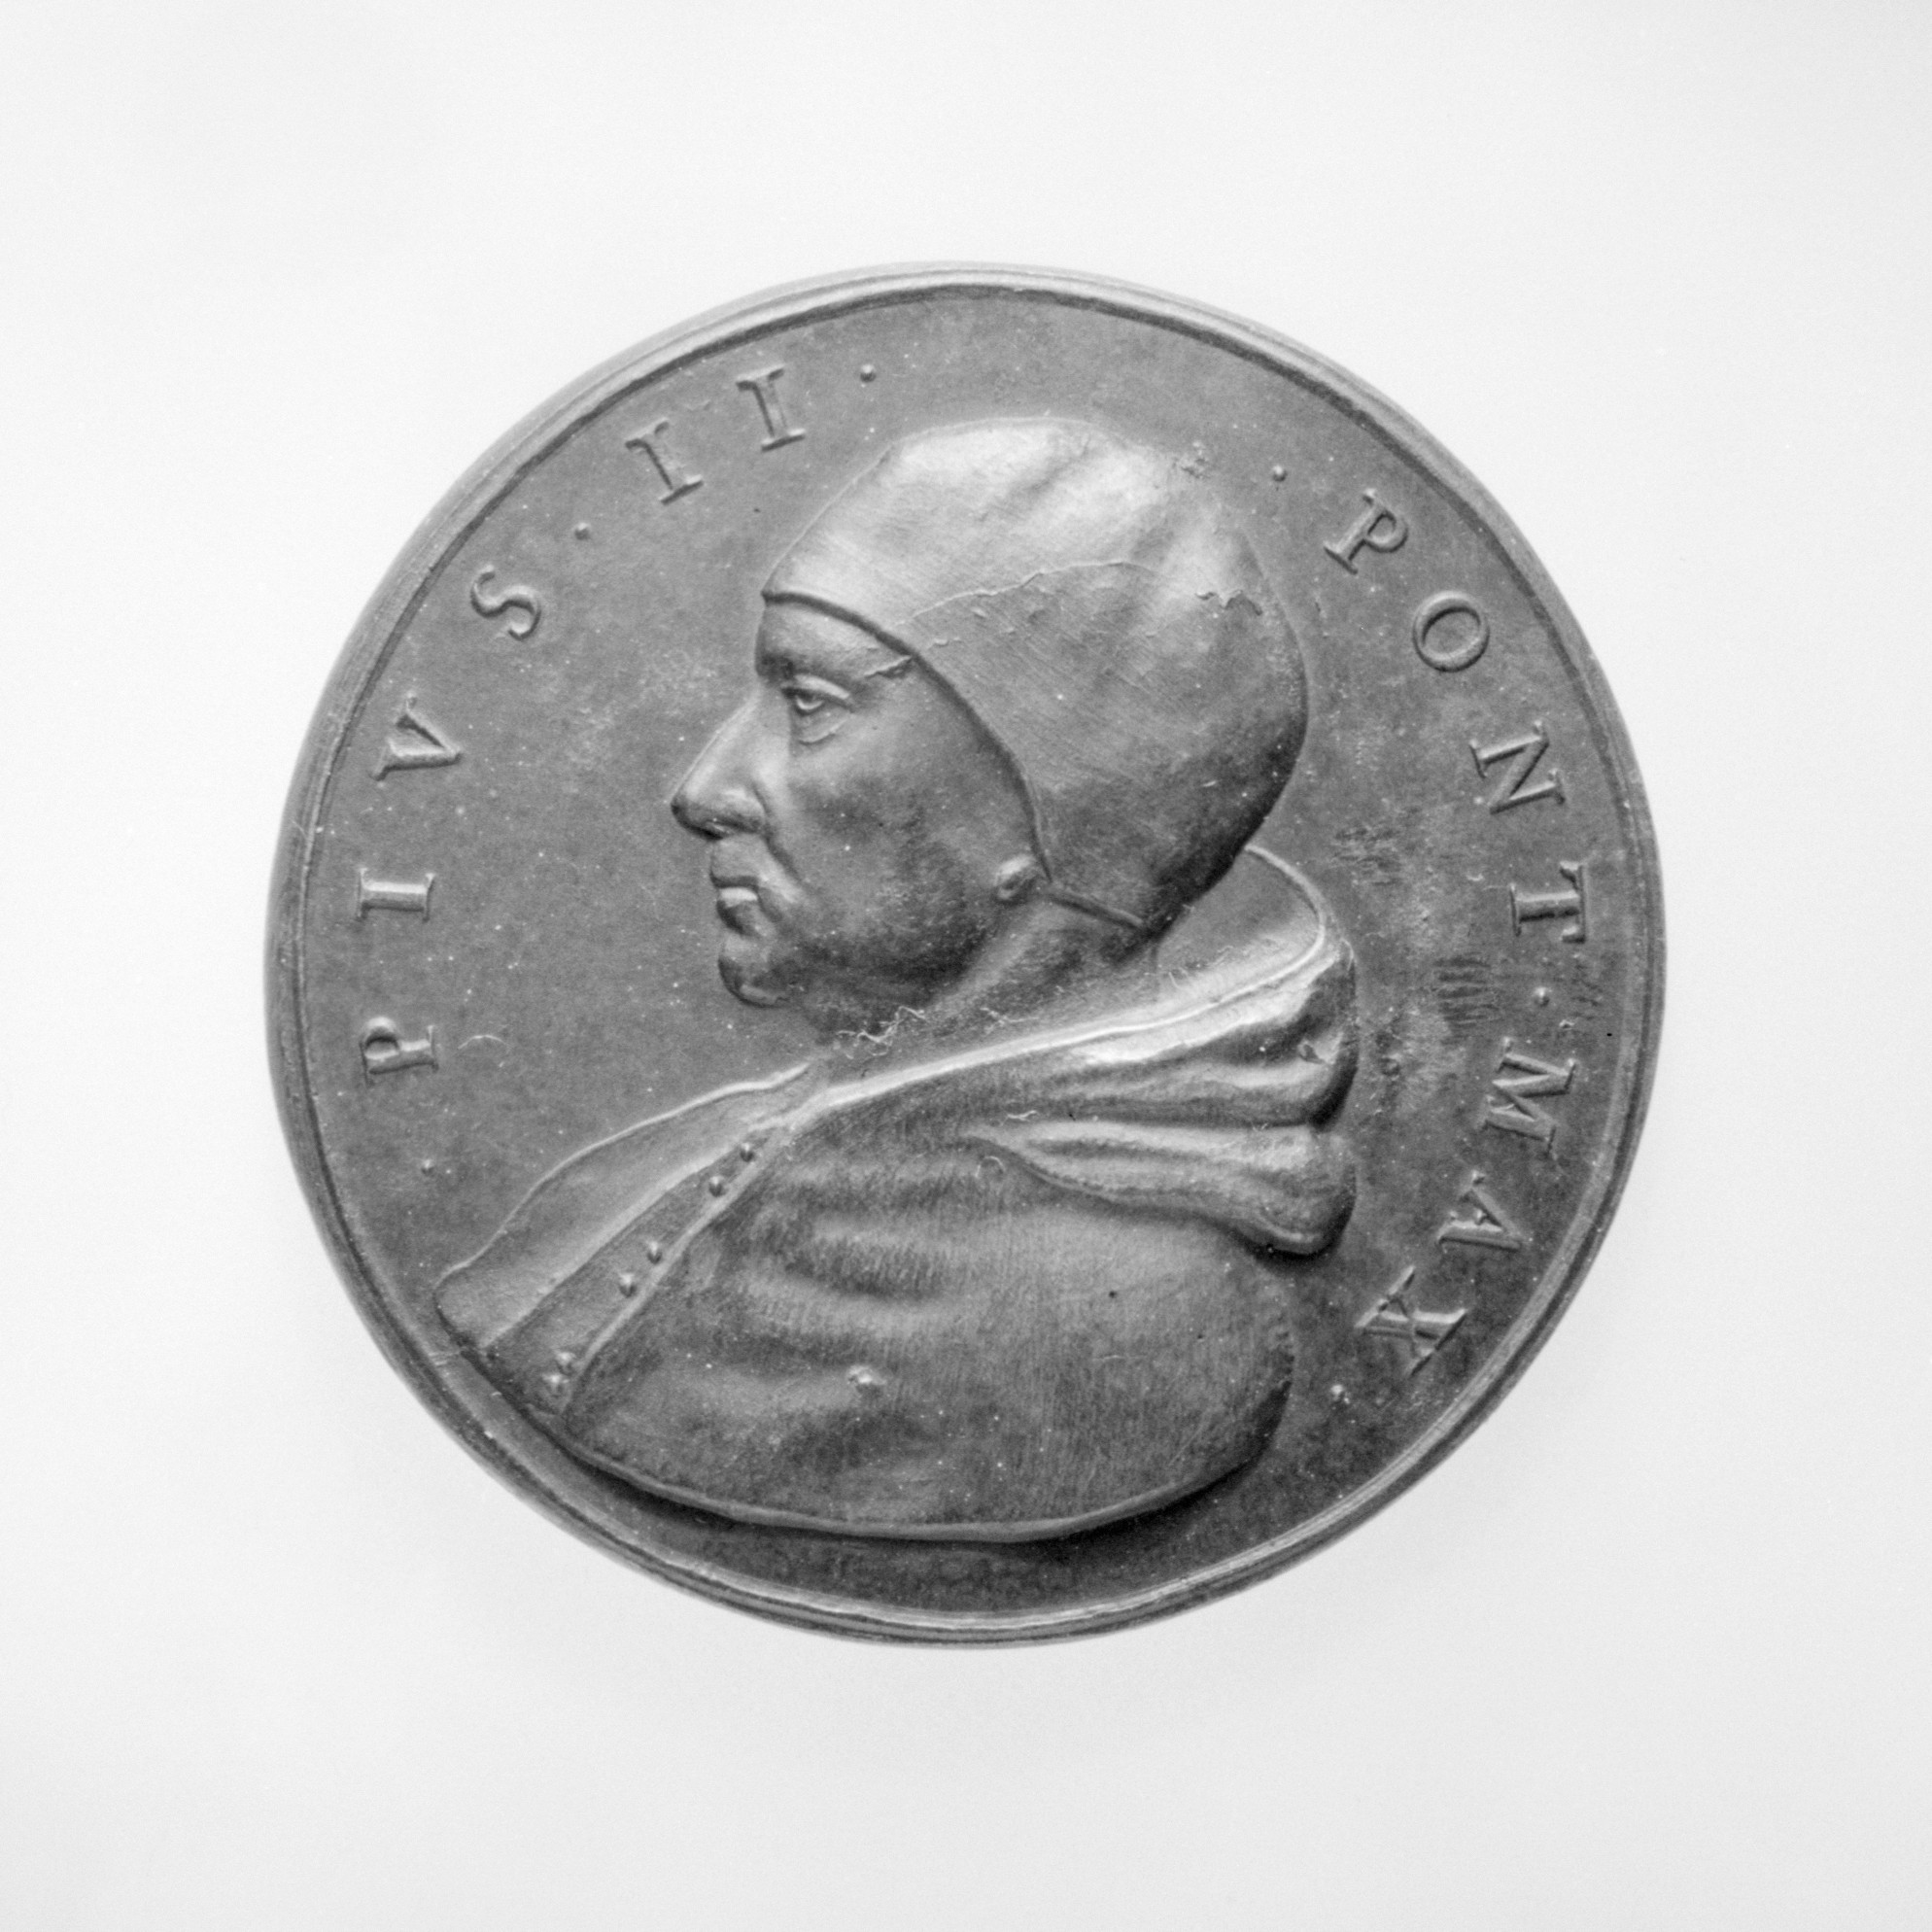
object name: medal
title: Pius II (Pope, 1458–64)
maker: giovanni paladino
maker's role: artist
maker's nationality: italian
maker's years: 1550-1650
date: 1567-1600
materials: bronze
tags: men,profiles,popes